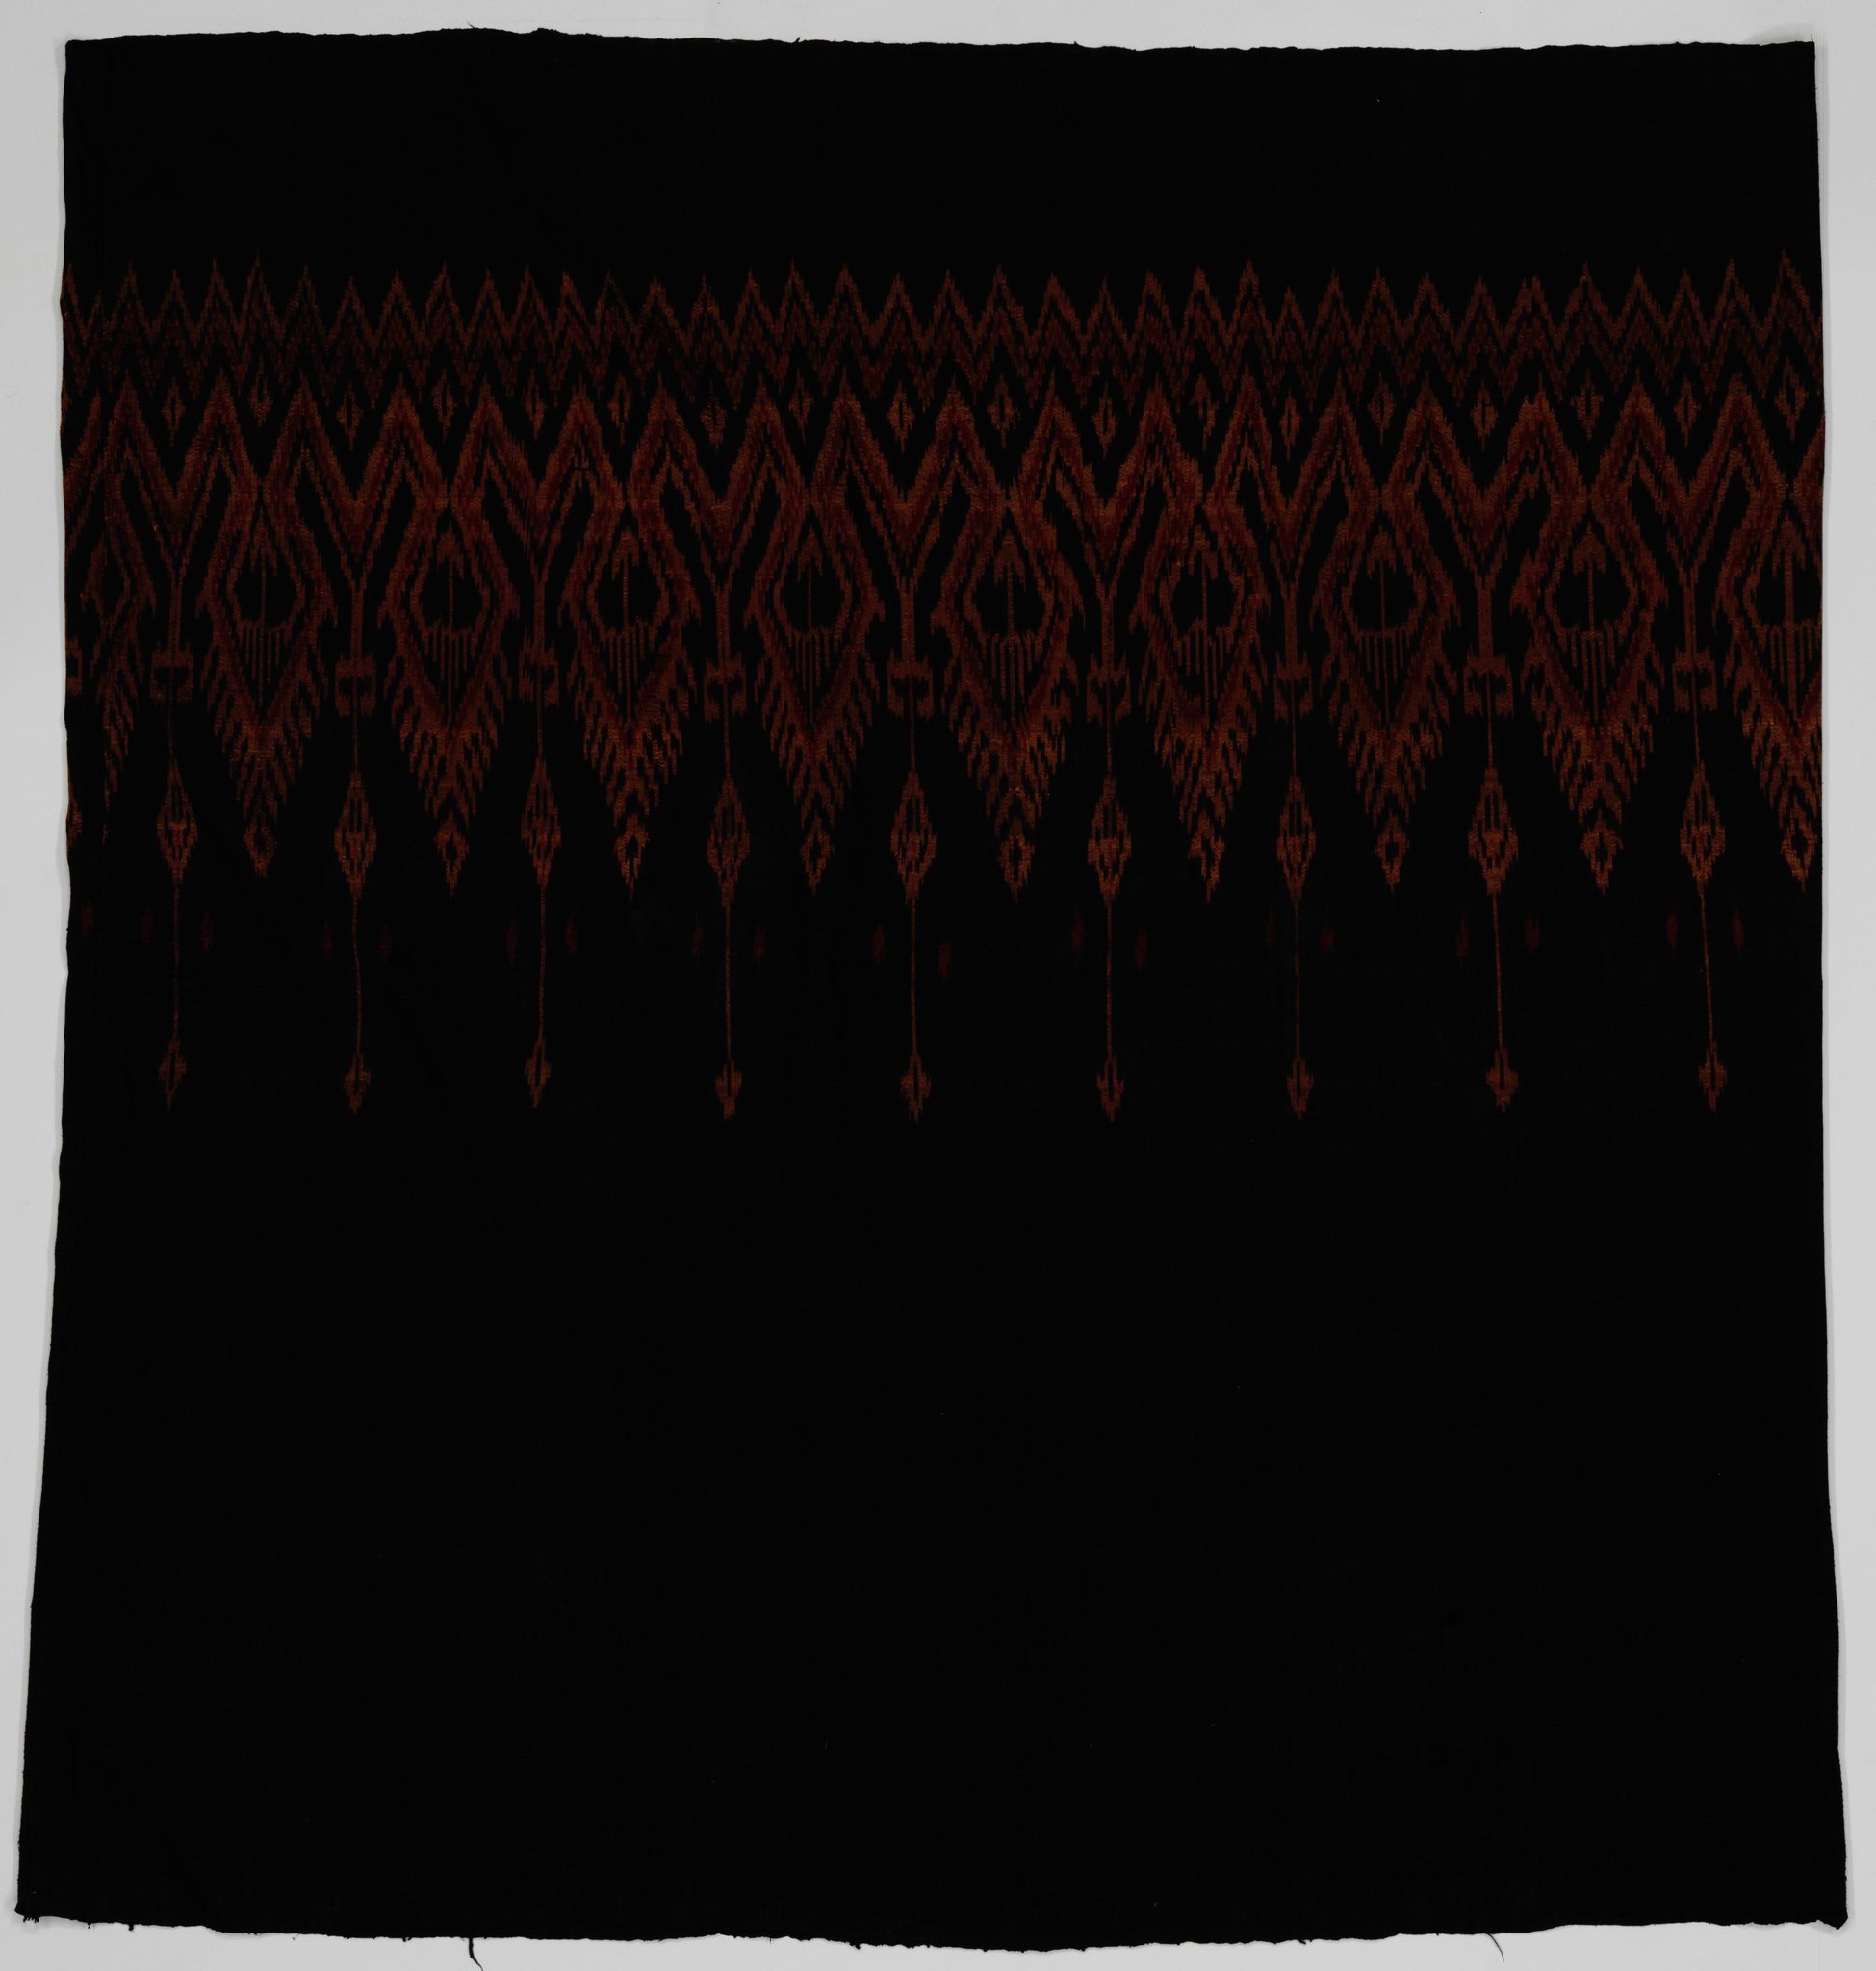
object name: cloth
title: Doek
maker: Anonymous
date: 1900-1949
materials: silk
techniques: weave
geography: thailand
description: Doek met florale en geometrische motieven.